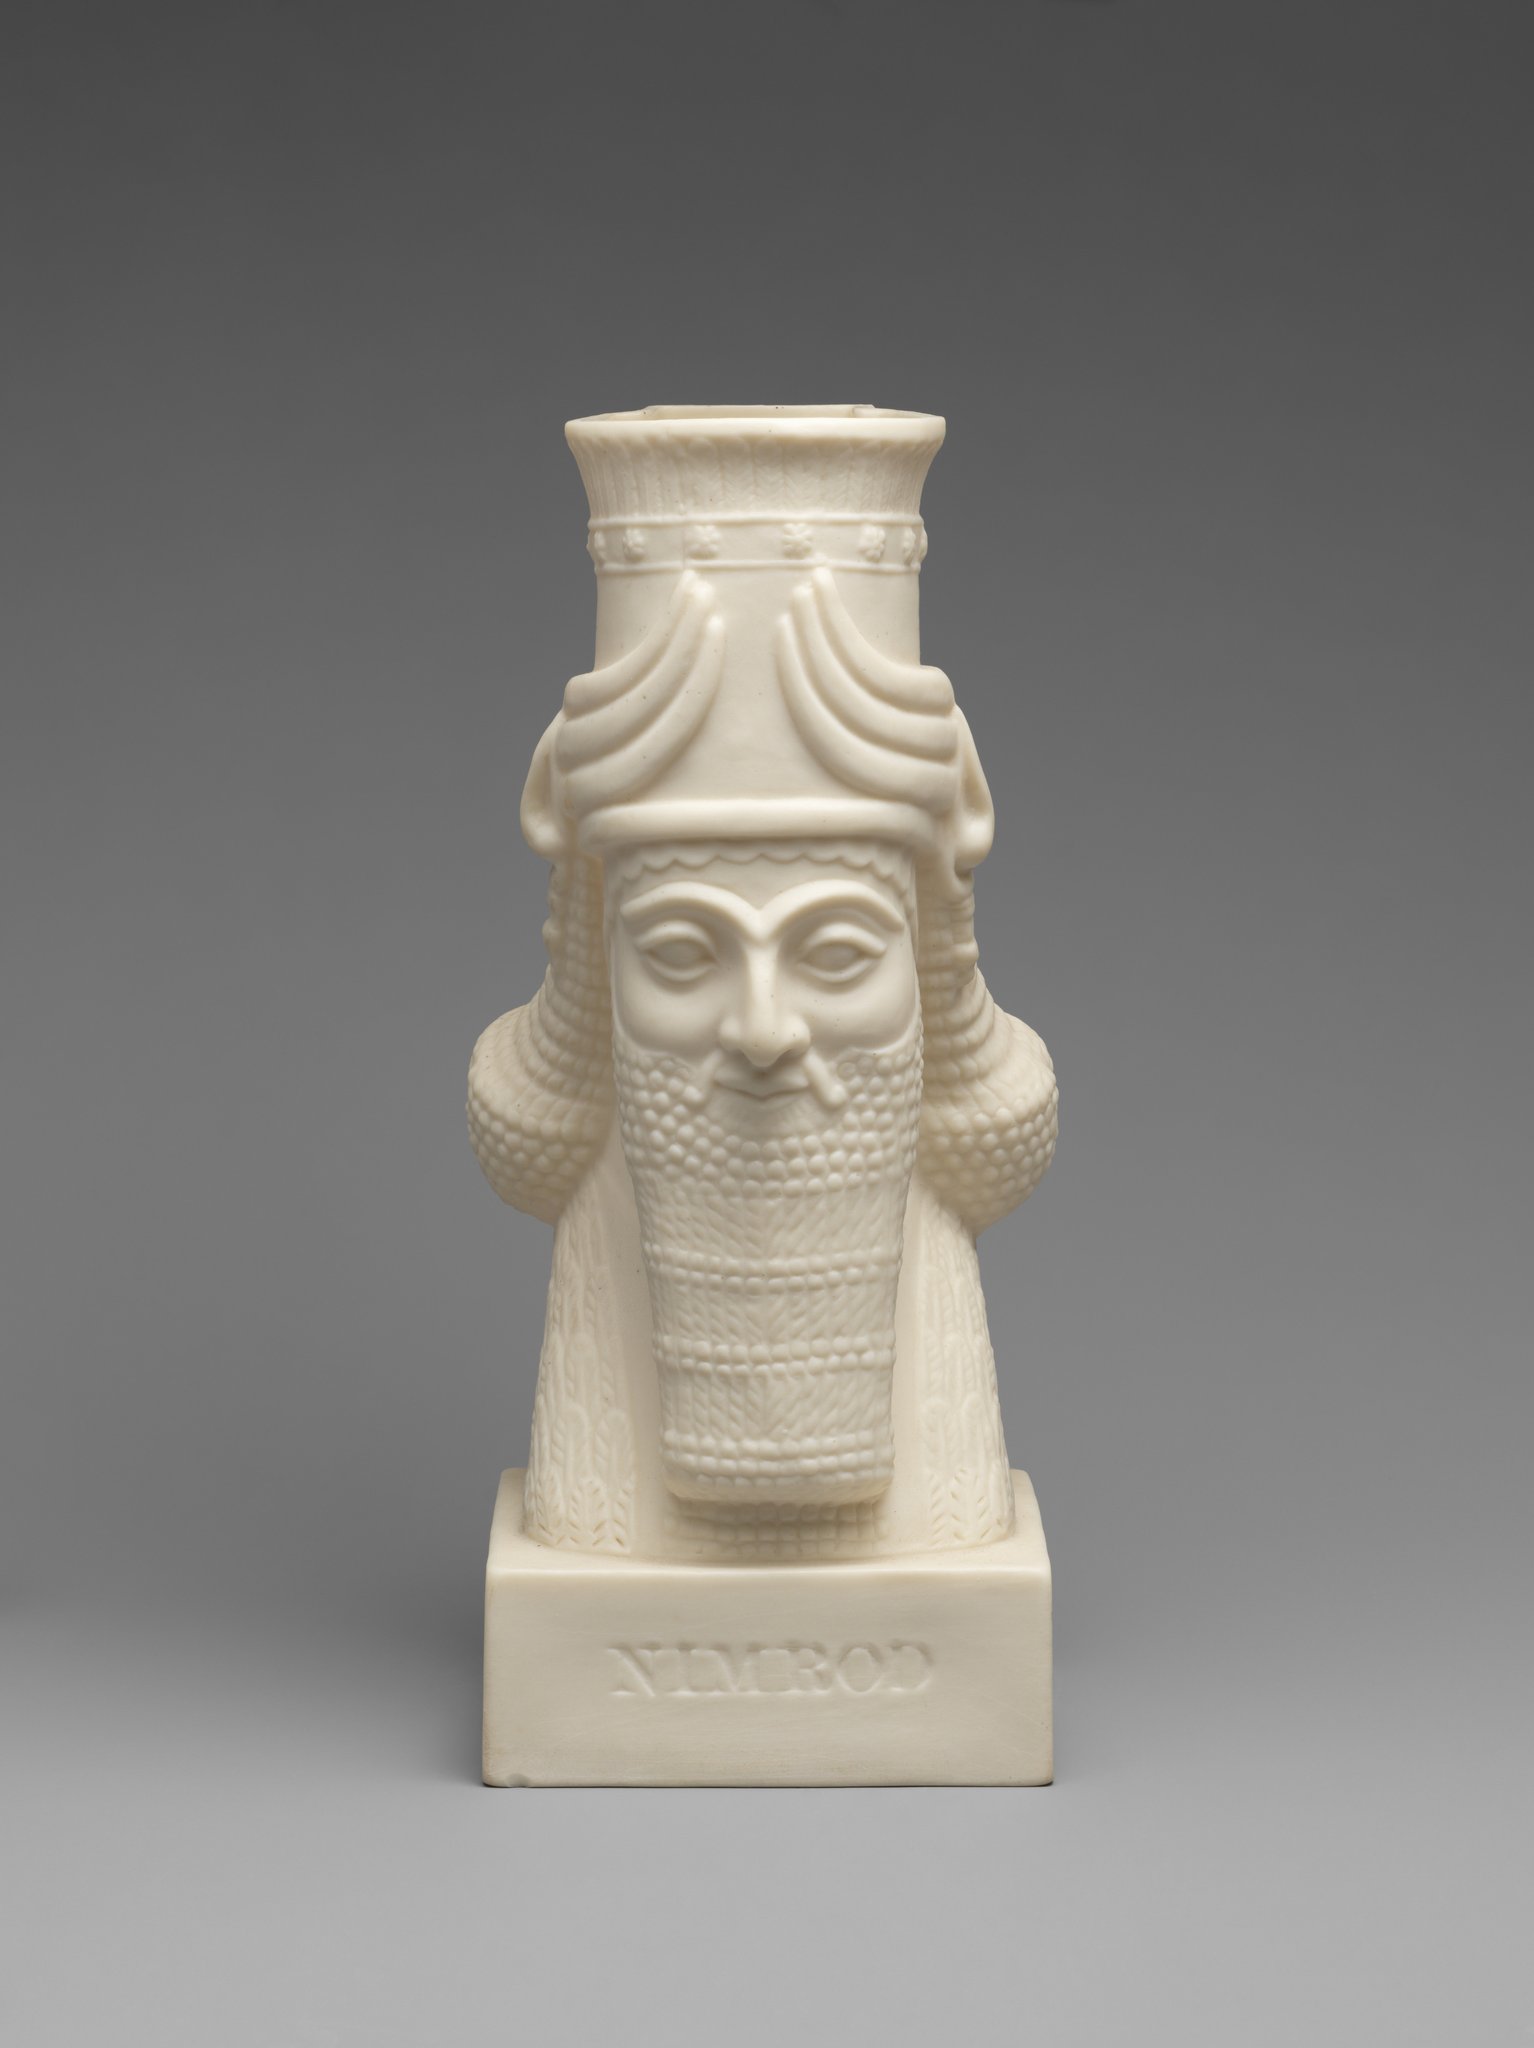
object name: vase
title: "Nimrod" flower vase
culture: british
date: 1868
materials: porcelain